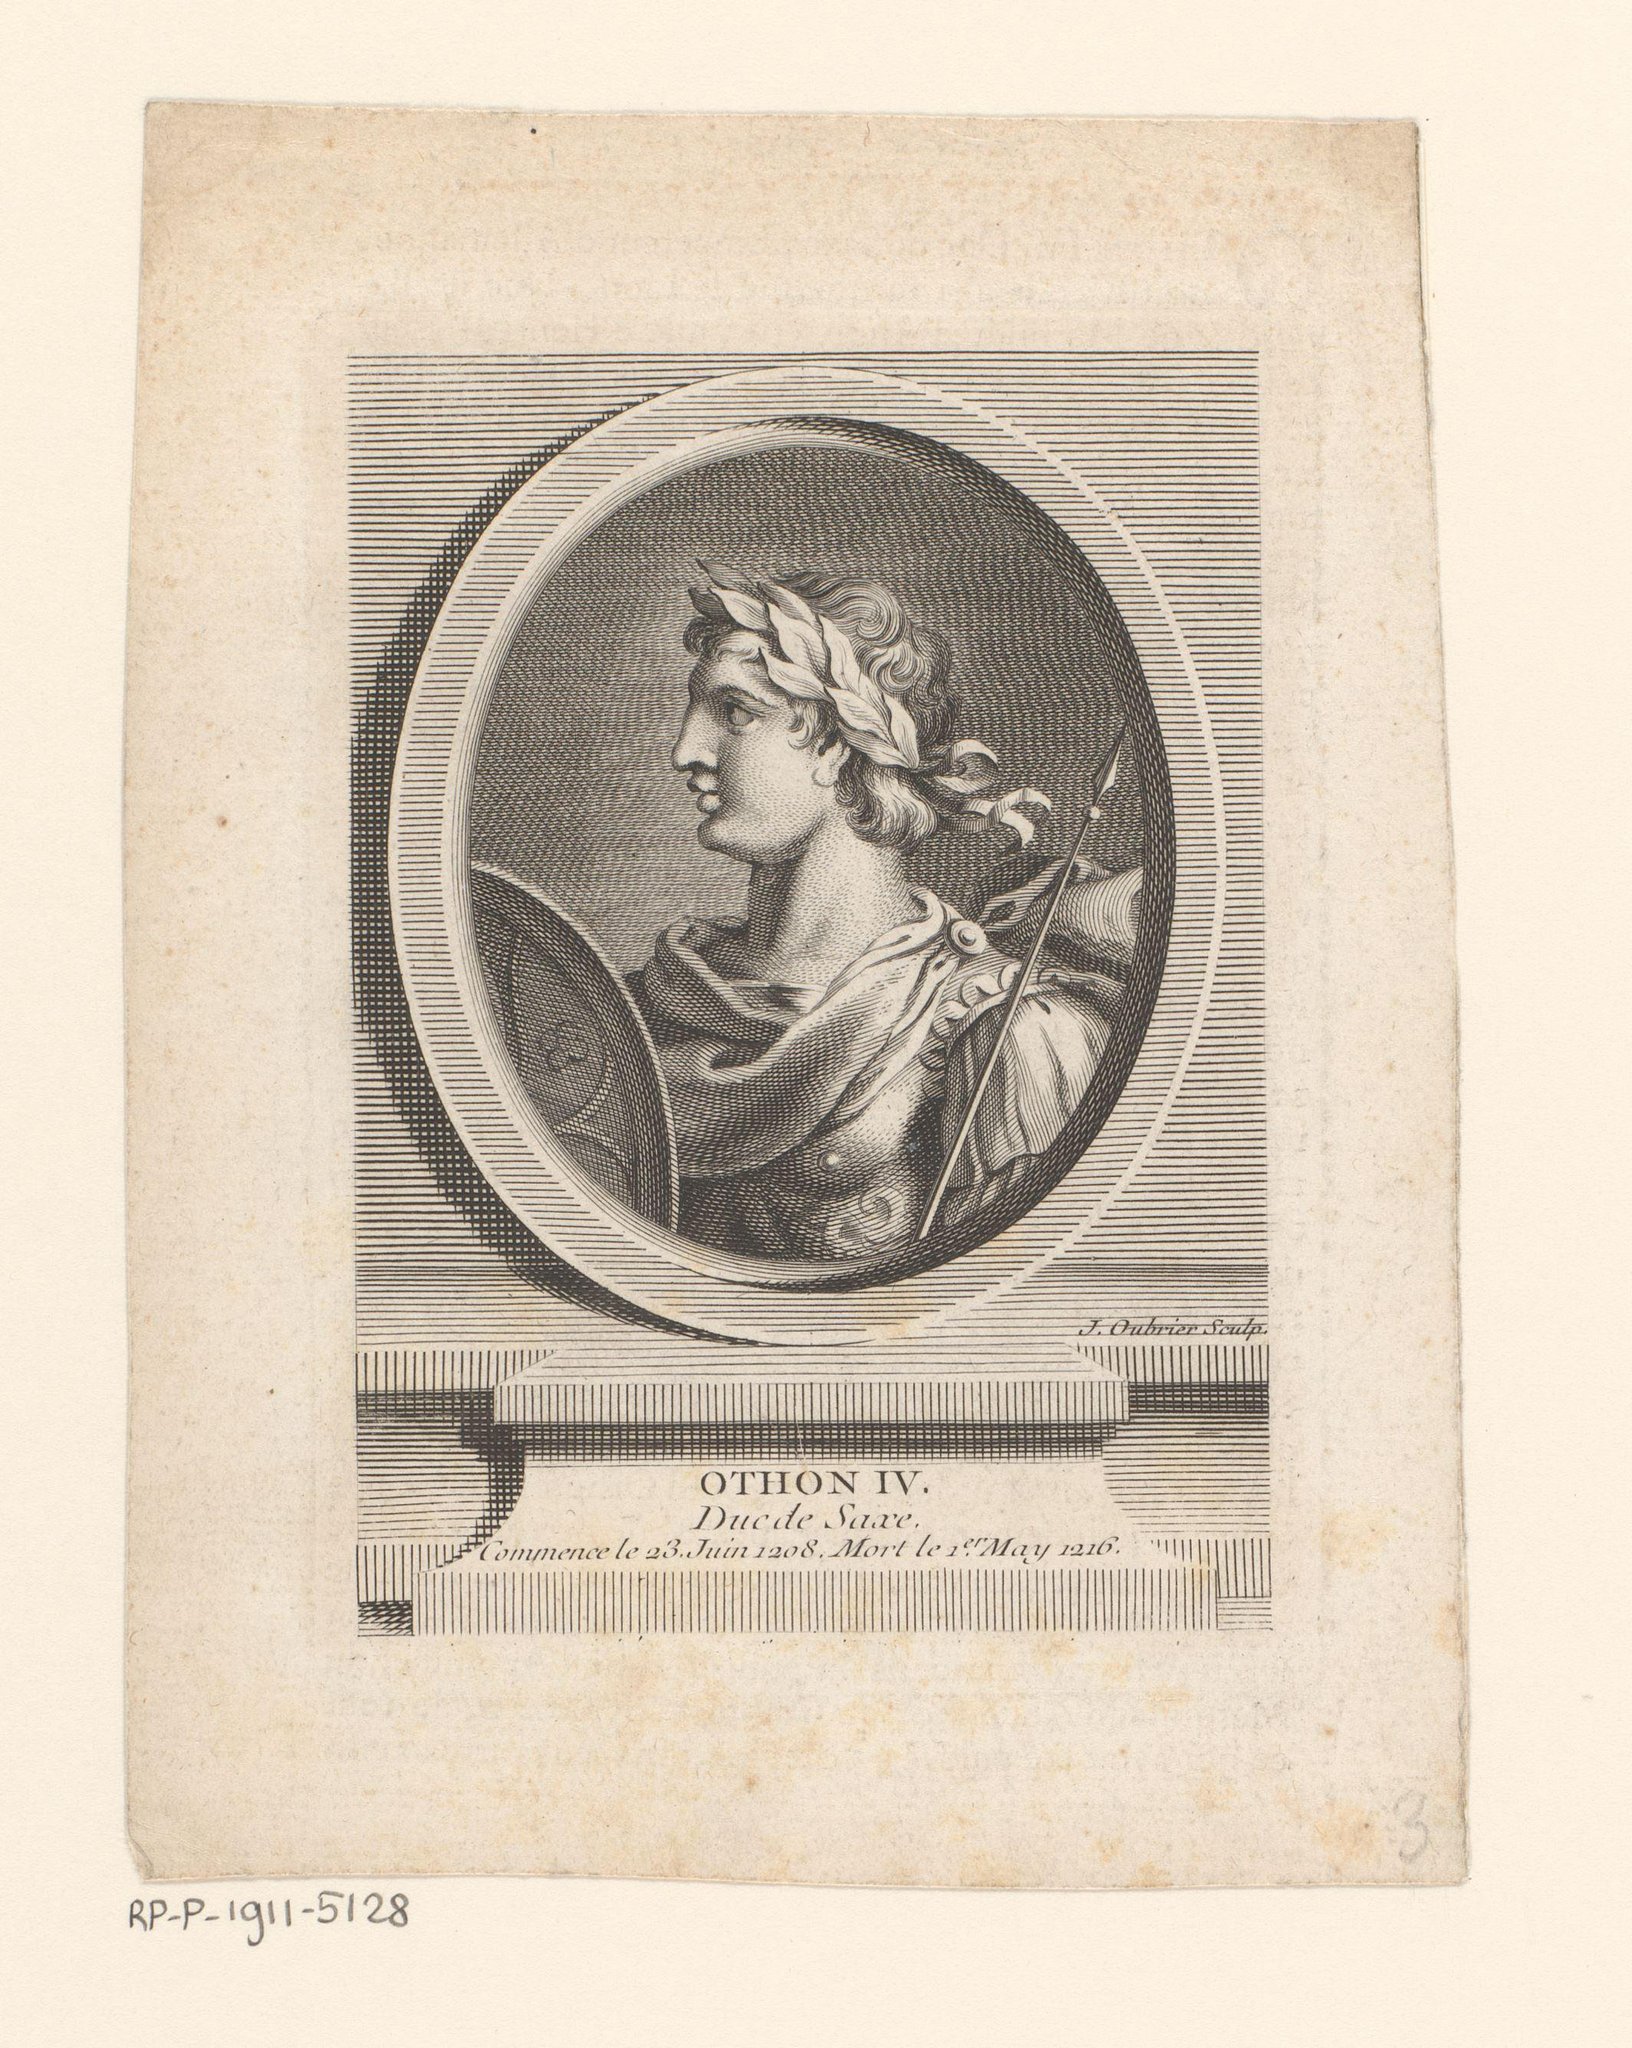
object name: book illustration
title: Portret van Otto IV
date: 1755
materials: paper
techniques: engraving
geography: paris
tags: historical persons, emperor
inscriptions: collector's mark: Lugt 2228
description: Prent uit: Dreux du Radier, Jean-François. L'Europe illustré, contenant l'histoire abregée des souverains, des princes, des prélats, des ministres, (...) en Europe: dans le XVe. siècle compris, jusqu'à présent. Parijs: Michel Odieuvre en André-François Le Breton, 1755.